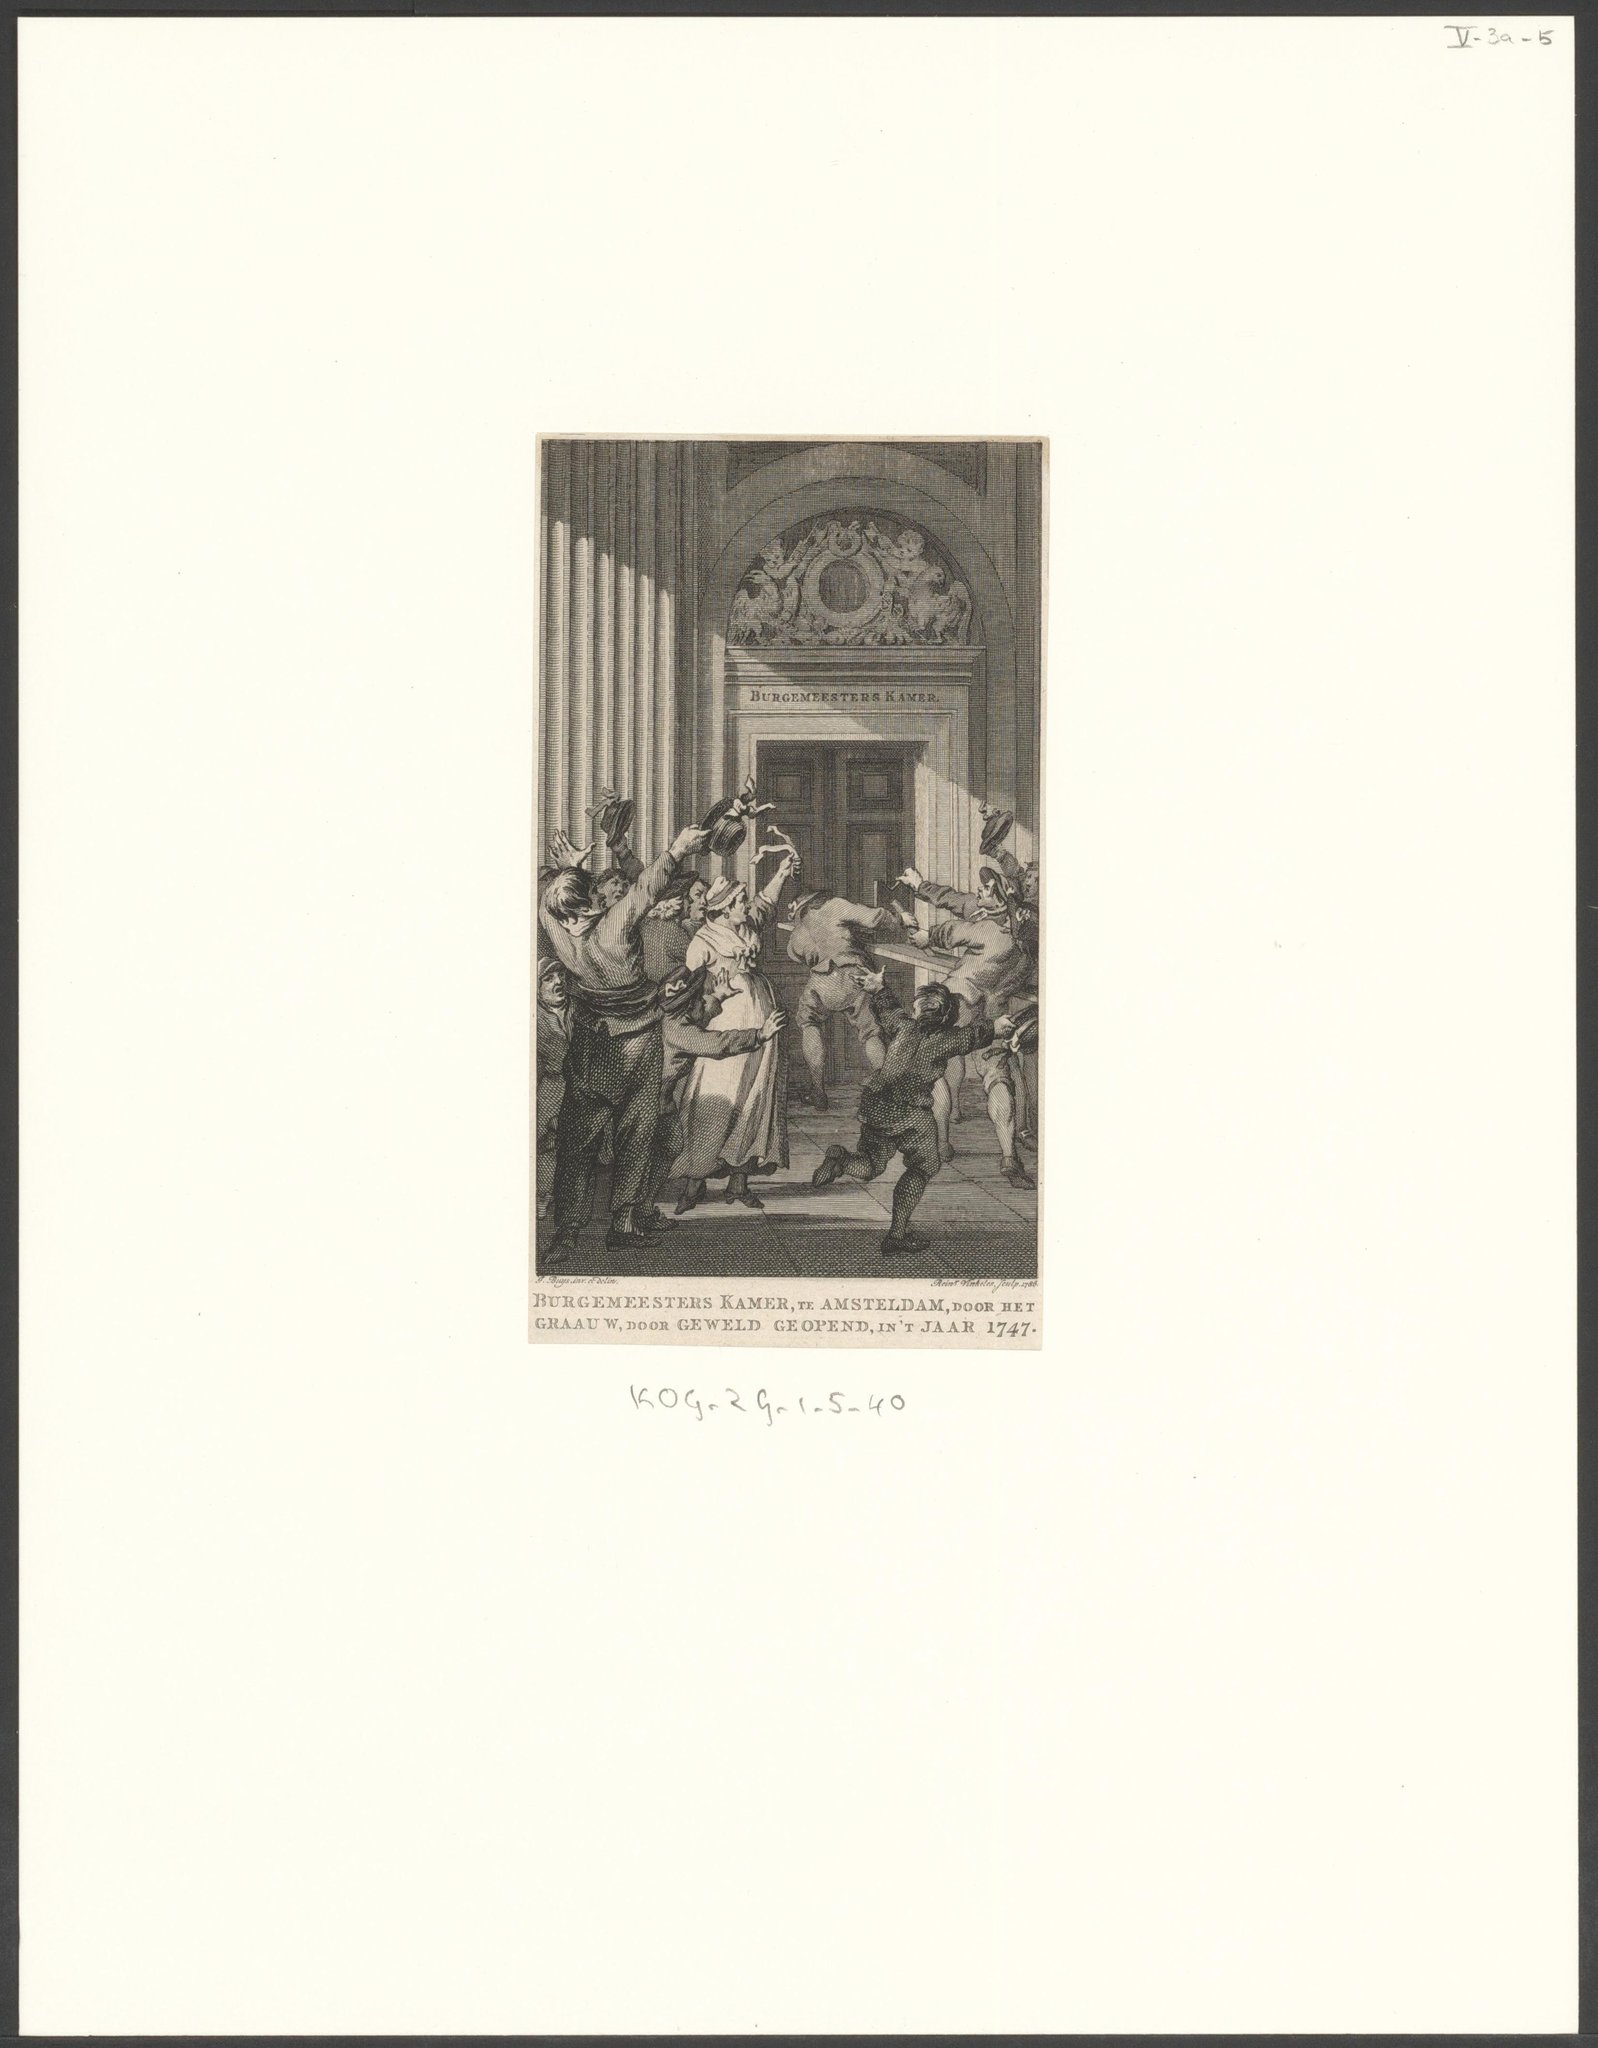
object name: print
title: Bestorming van de burgemeesterskamer in het stadhuis van Amsterdam, 1747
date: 1786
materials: paper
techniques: engraving, etching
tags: townhall, street-fights, riots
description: Oproerig volk breekt met geweld de burgemeesterskamer in het stadhuis van Amsterdam open, 9 november 1747. Onderwerpsrubrieken binnen de Atlas Zeden en Gewoonten: Krijgswezen, Schutterij, Historieprenten.